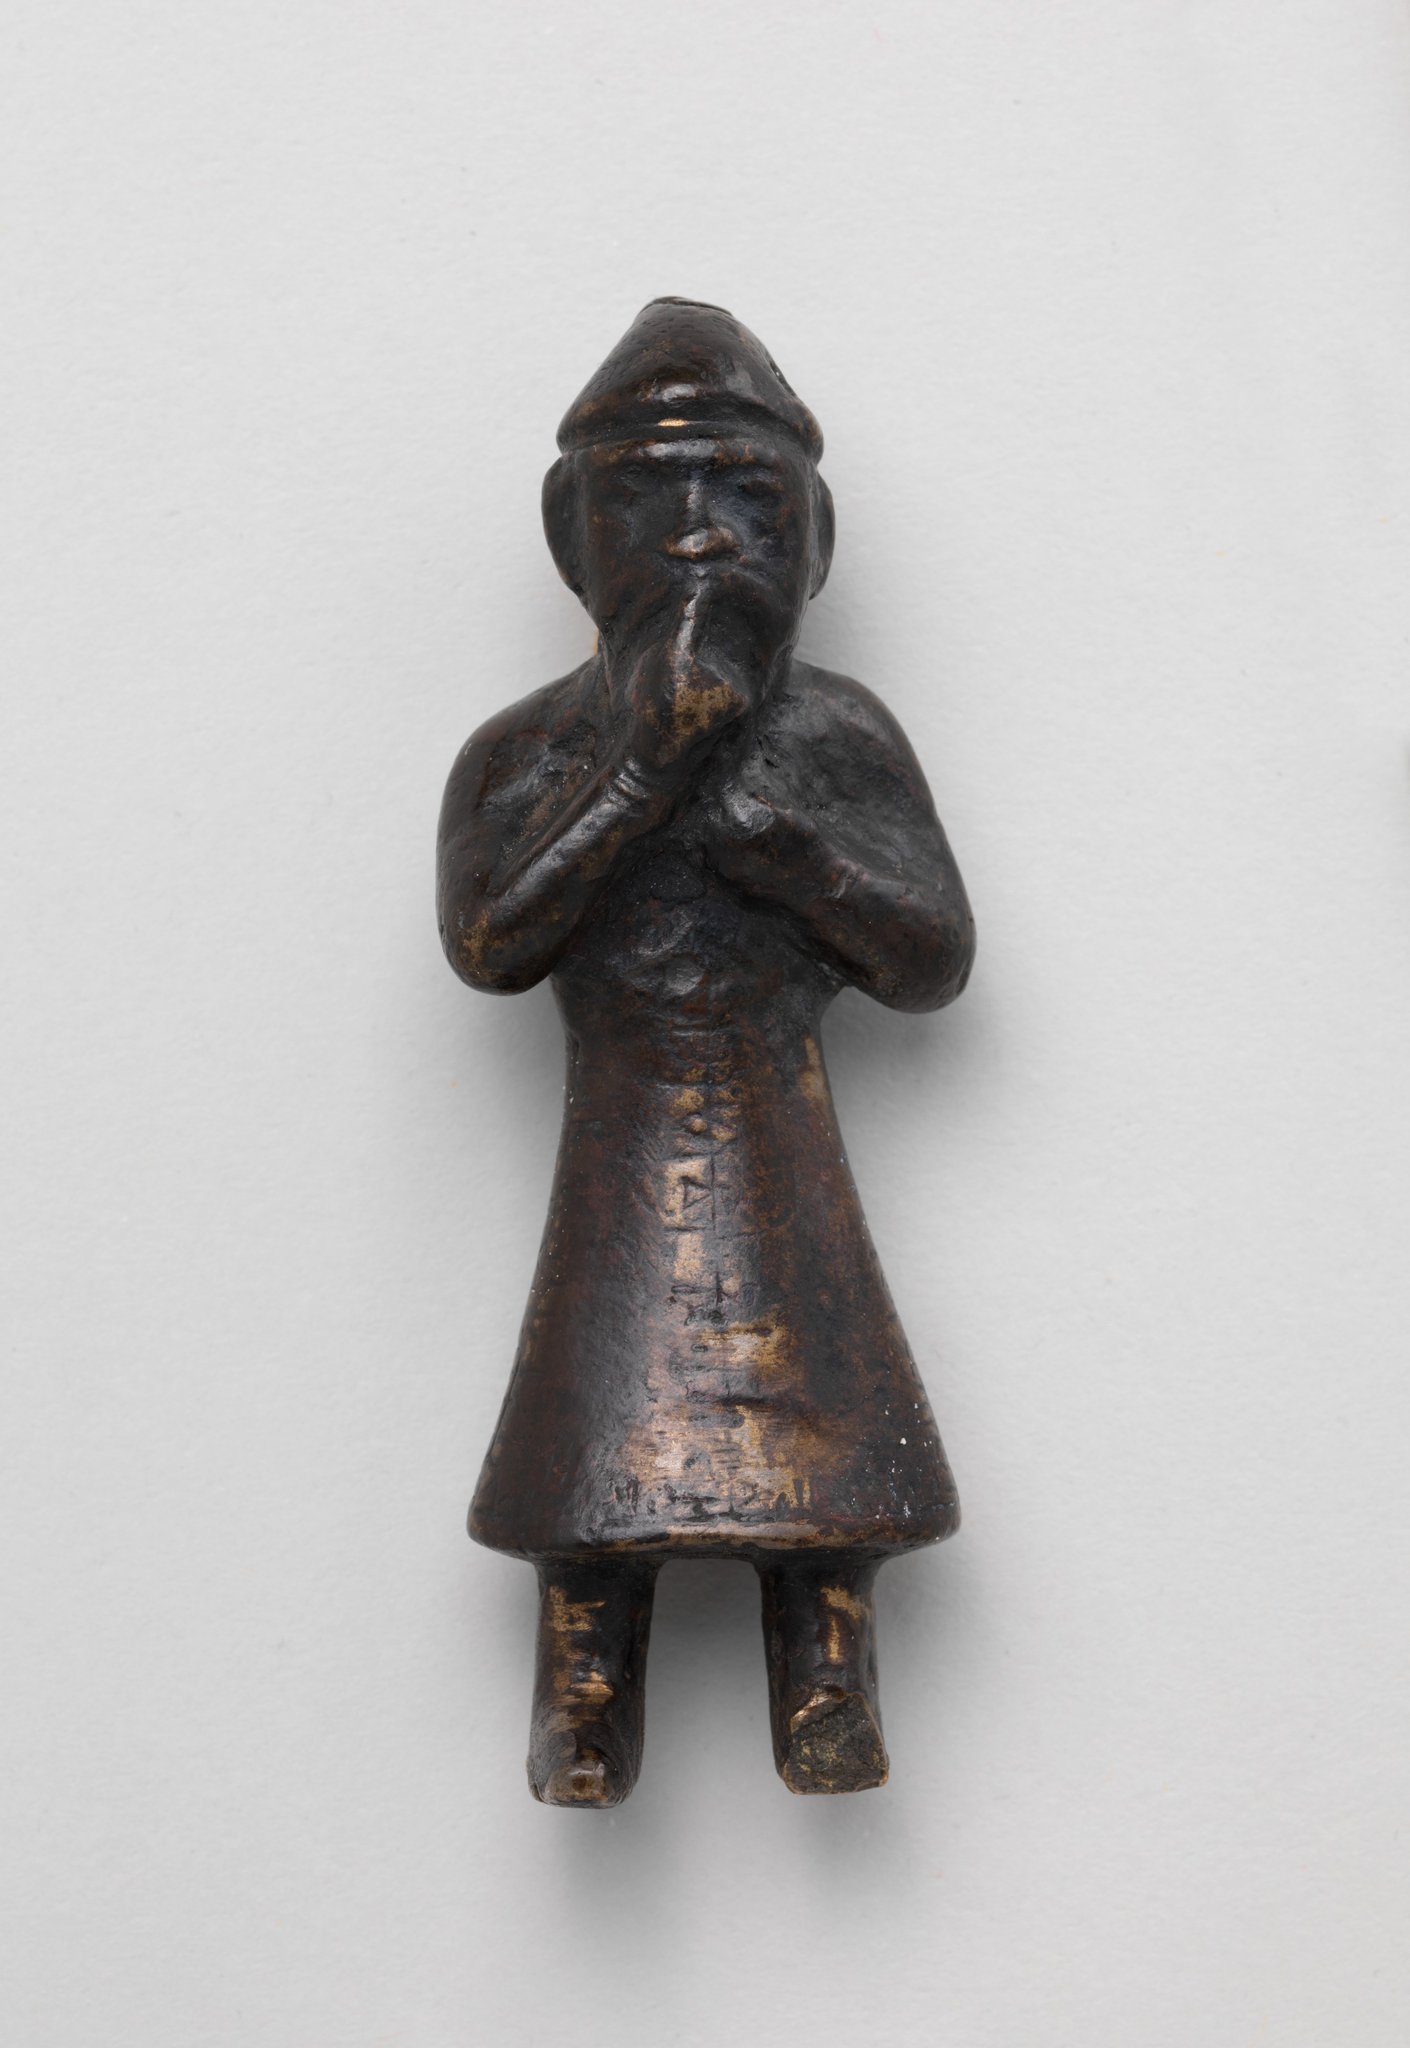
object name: figure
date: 1001-1200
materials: bronze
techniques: casting, chasing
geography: central asia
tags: men